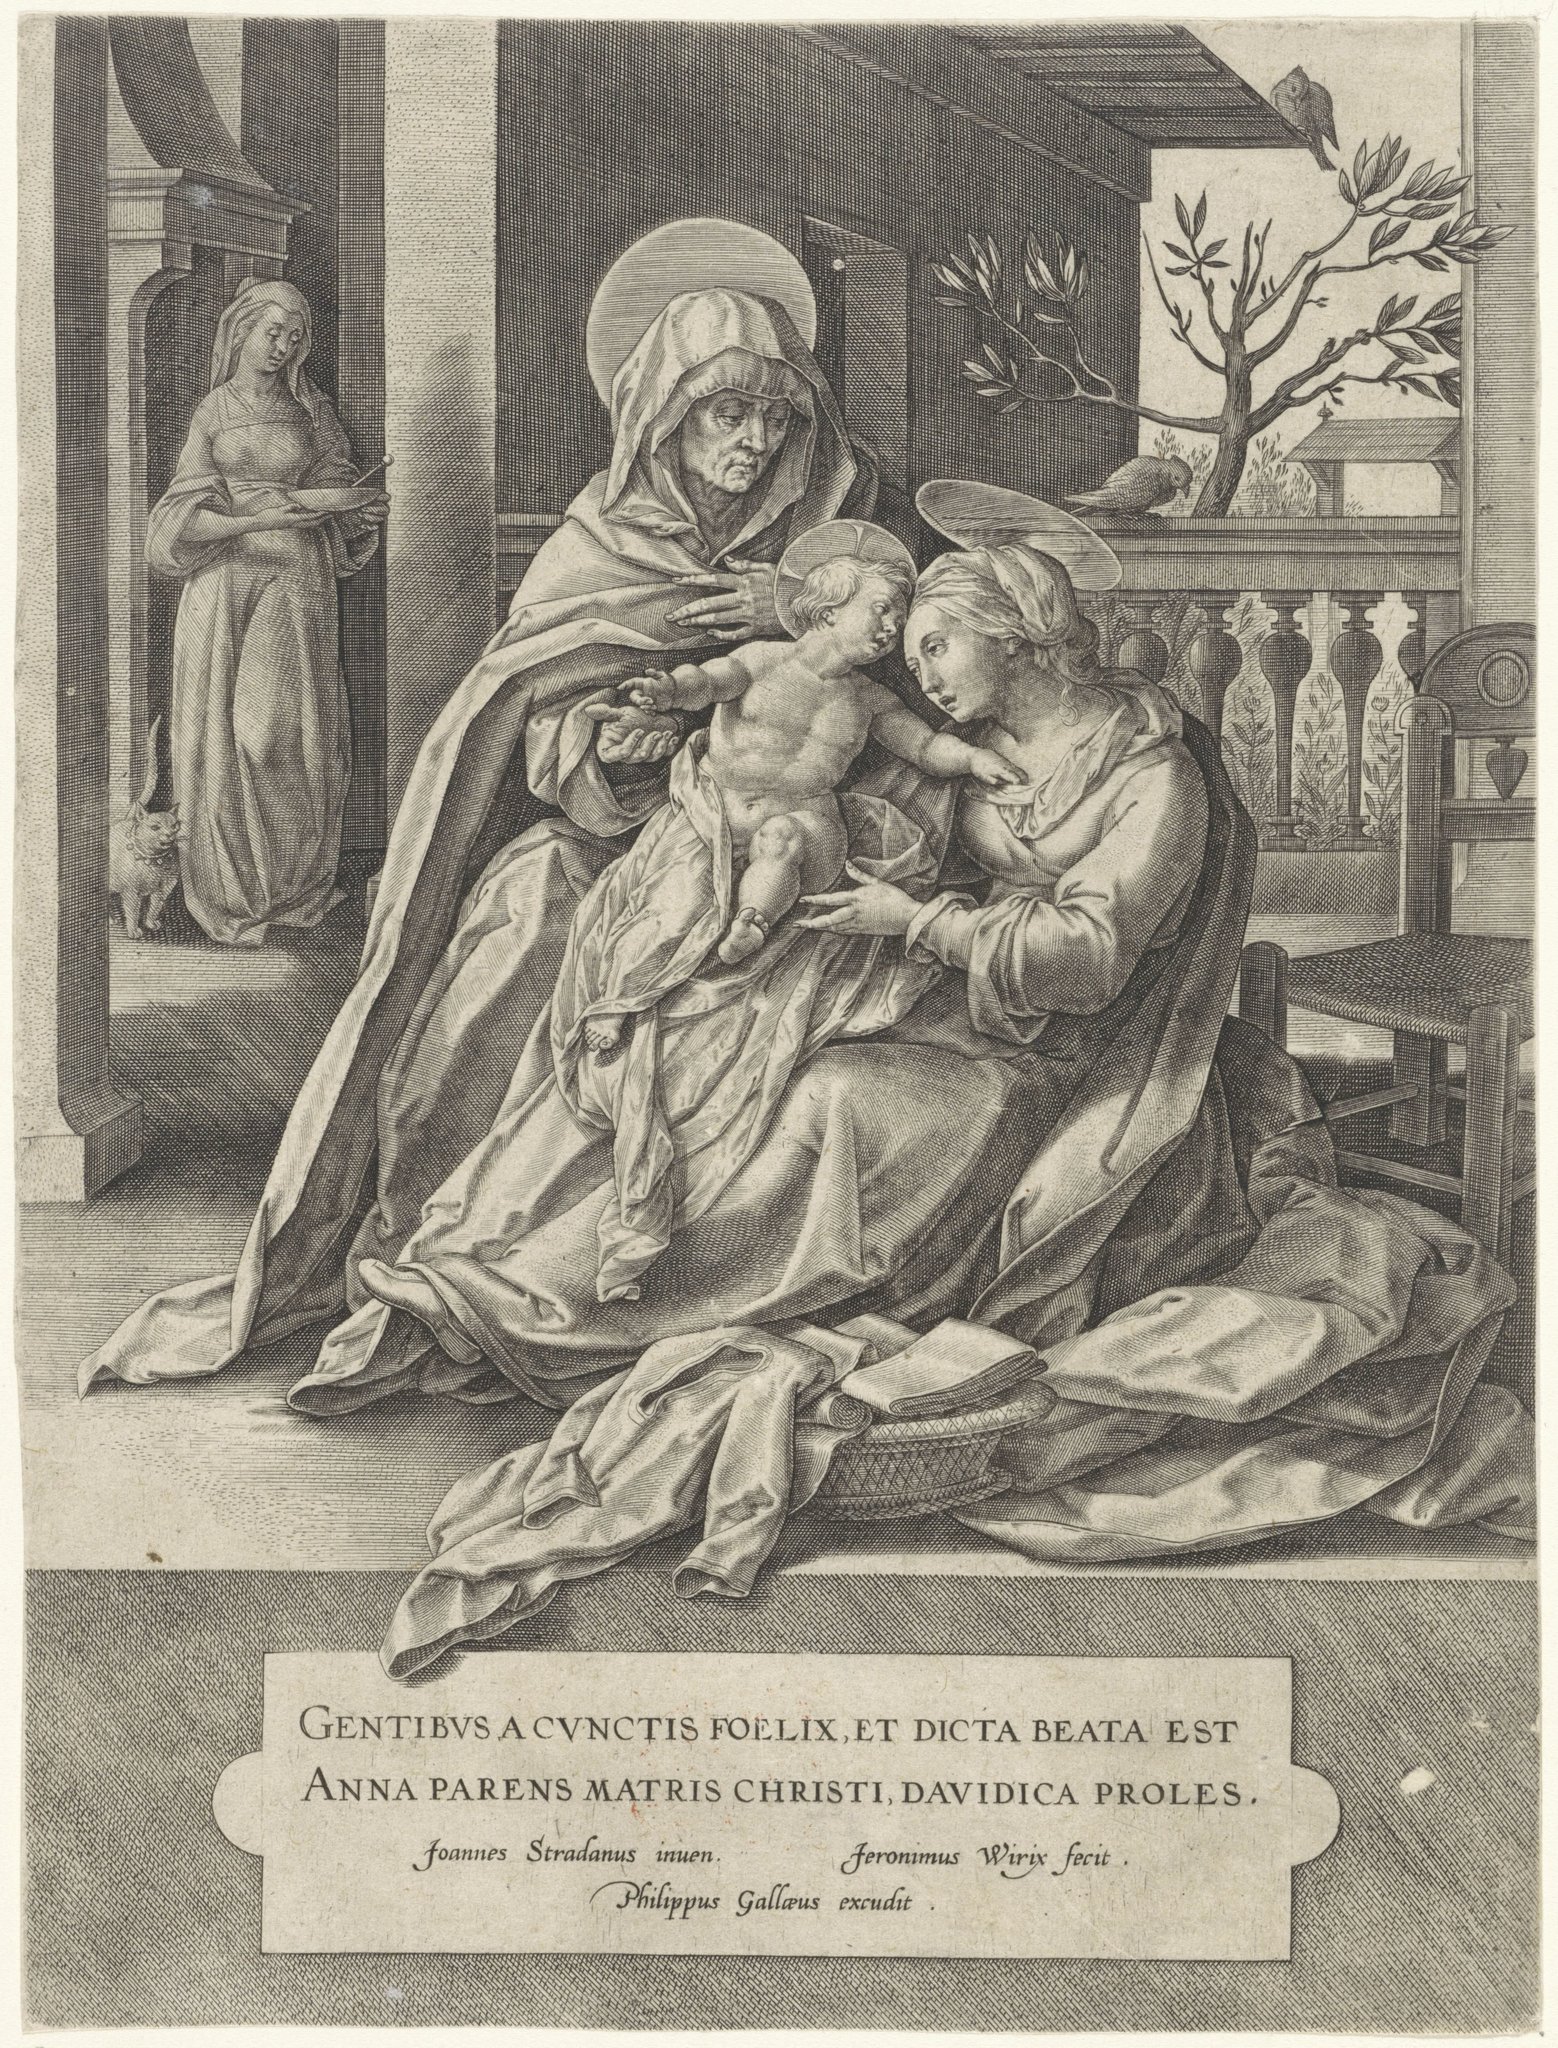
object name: print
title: Anna te Drieën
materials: paper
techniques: engraving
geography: antwerp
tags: 'anna selbdritt', i.e. anna, mary and christ-child close together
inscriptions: collector's mark: Lugt 2228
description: Maria zit met het Christuskind op schoot. Anna zit dicht bij hen. Op de achtergrond een bediende. In de tuin van het huis zitten twee duiven, één op de dakrand, en één op het hek. In het kader in de marge een tweeregelig onderschrift in het Latijn.